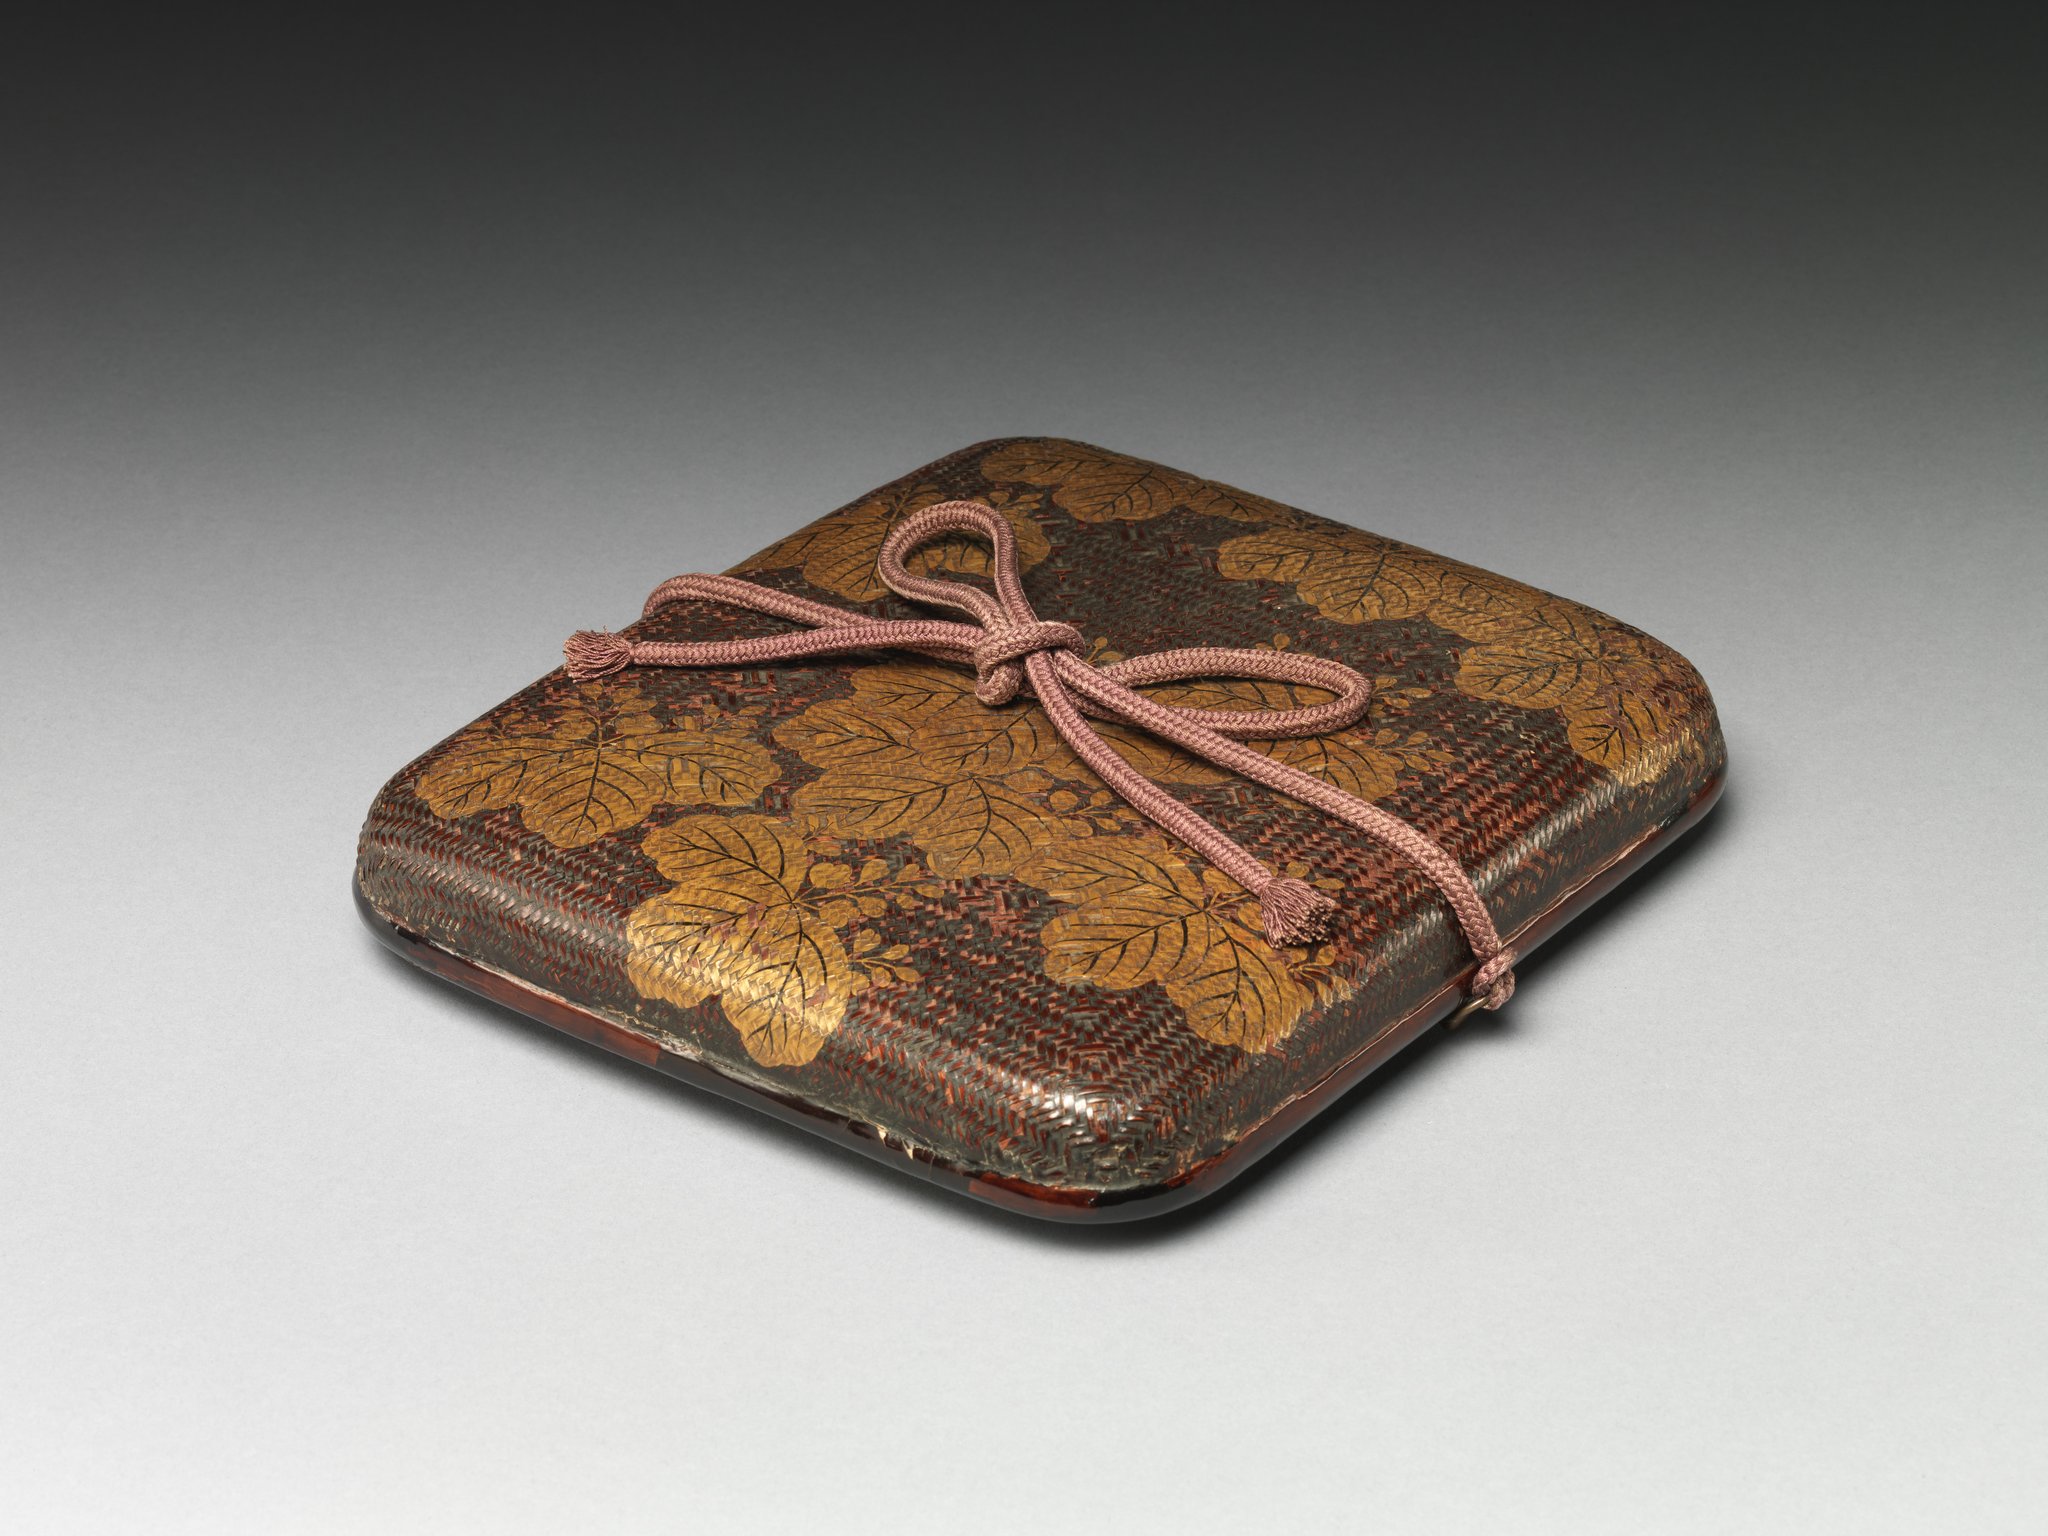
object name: box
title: Basketry Box for Square Calligraphy Paper (Shikishibako) with Paulownia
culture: japanese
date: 1601-1633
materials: bamboo, gold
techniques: hiramakie, lacquer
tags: leaves